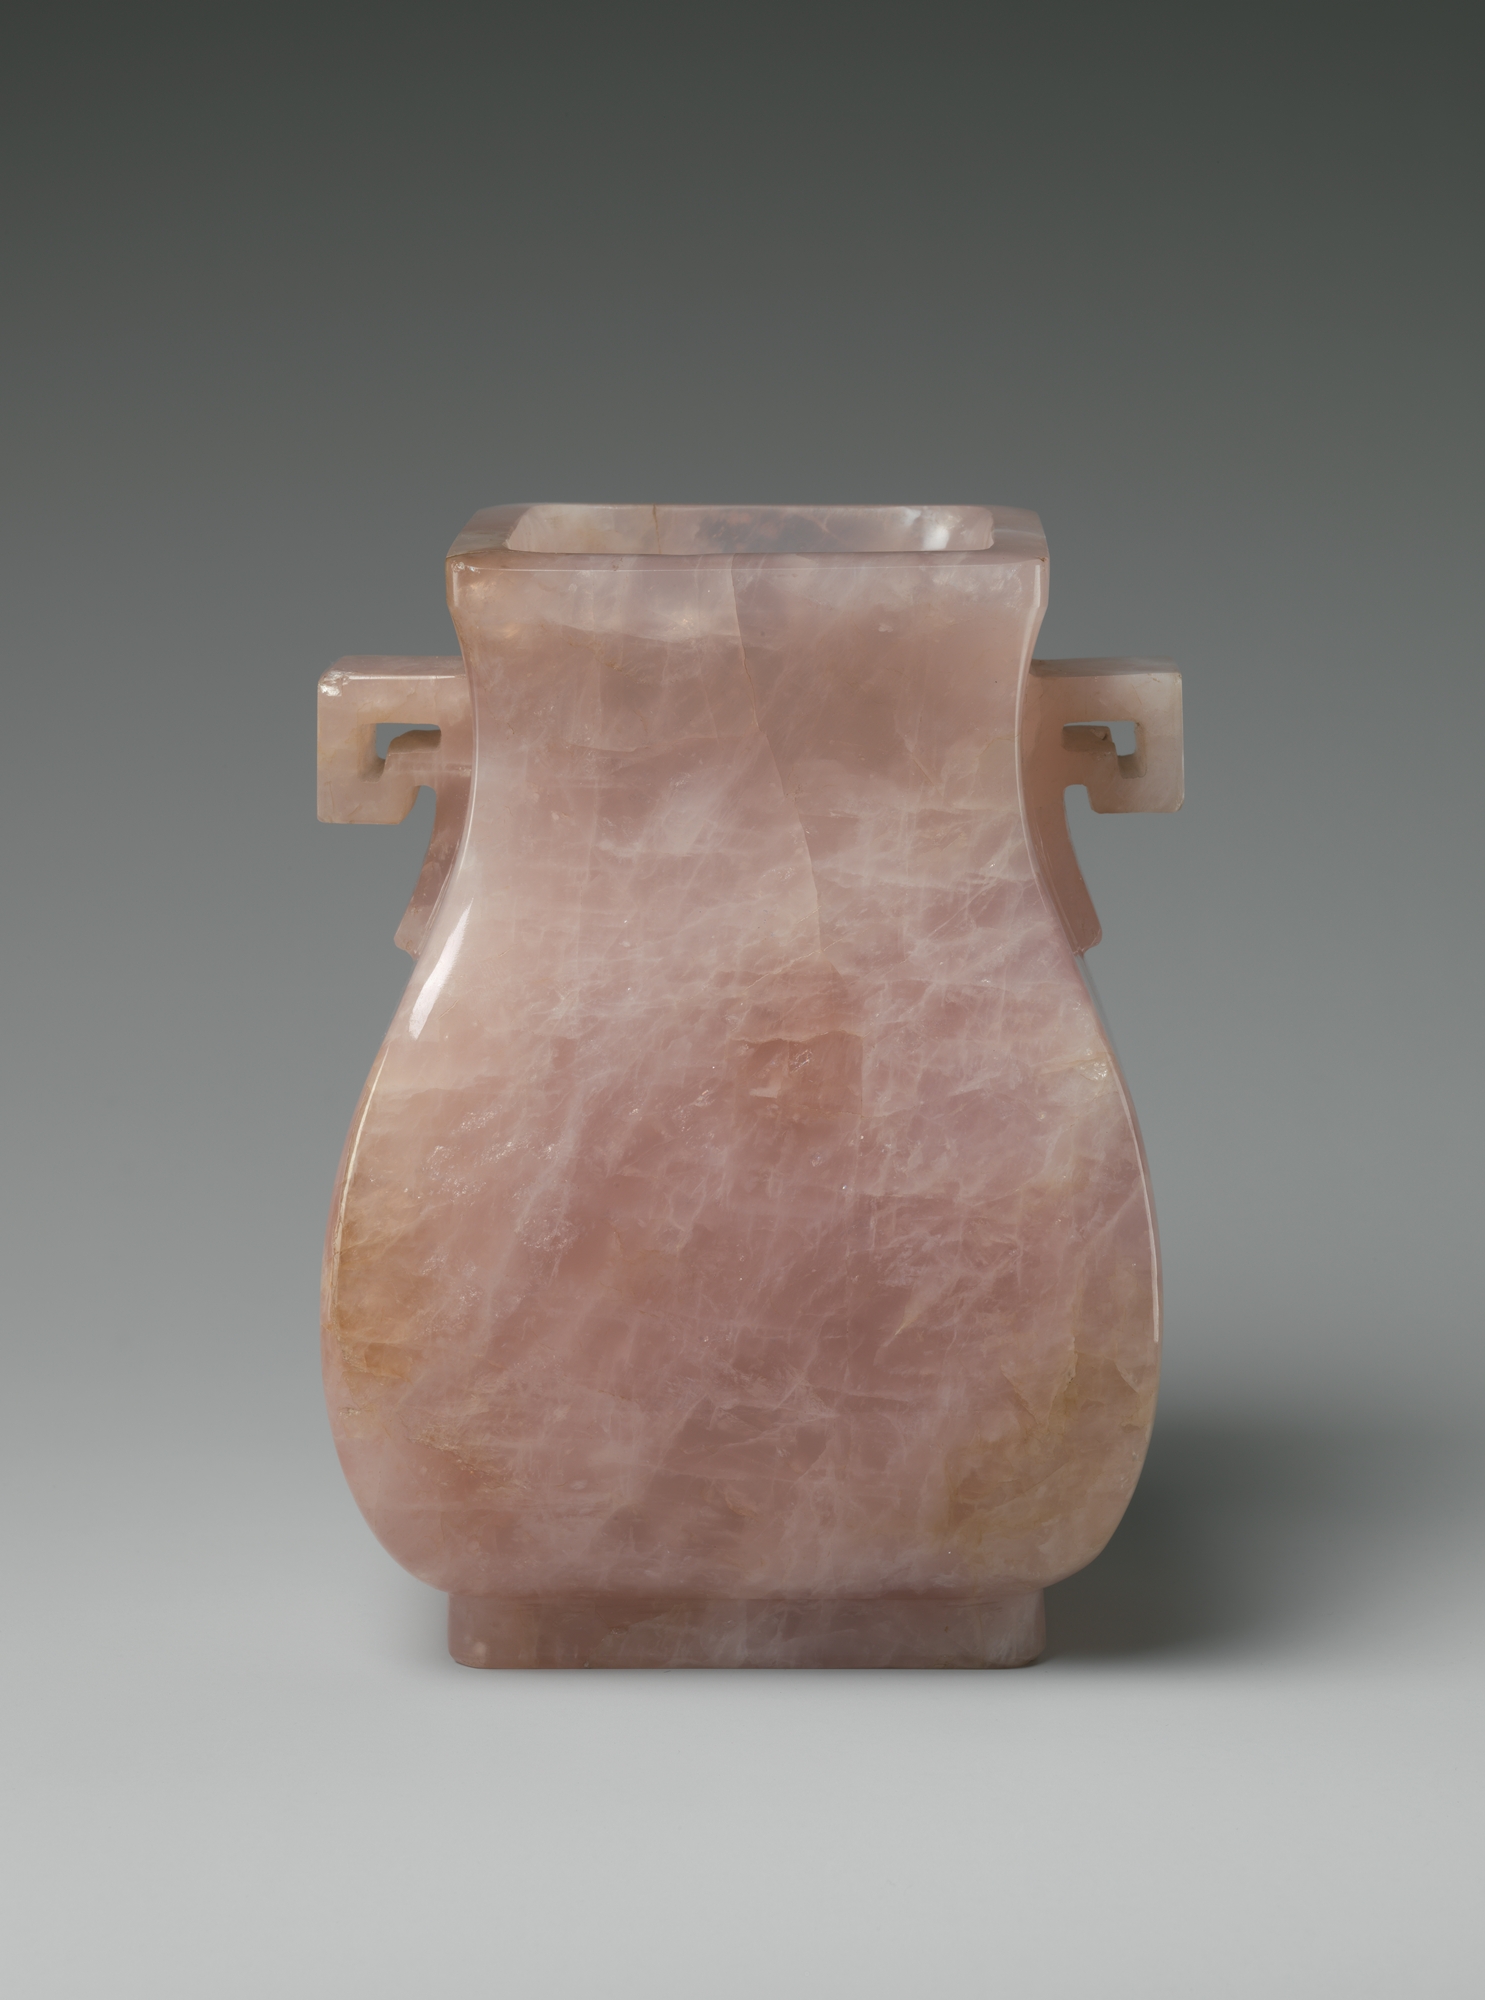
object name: vase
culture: chinese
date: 1701-1800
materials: quartz